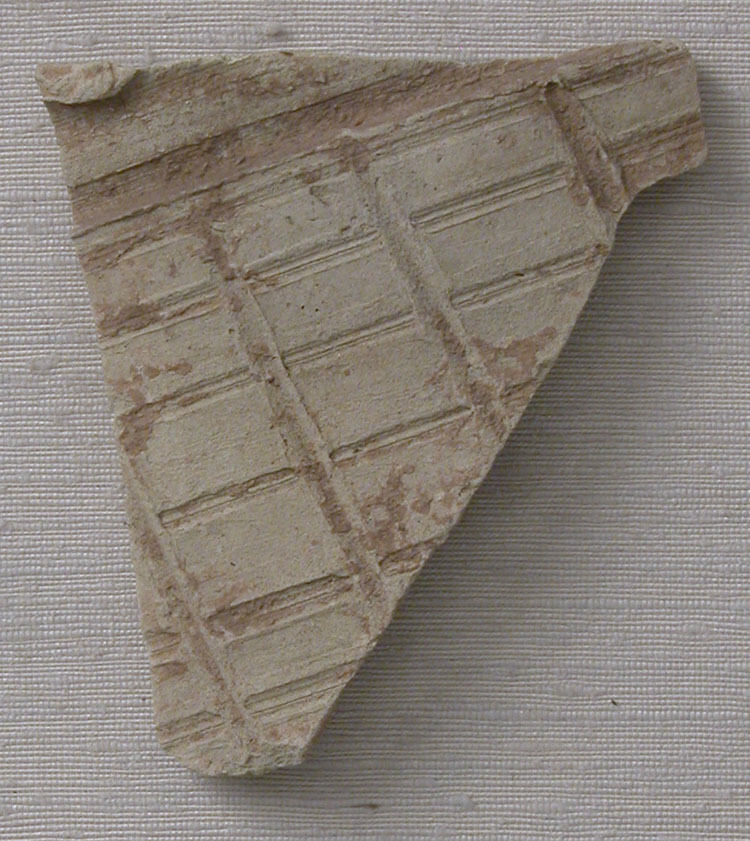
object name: fragment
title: Ceramic Fragment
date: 701-900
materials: earthenware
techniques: incising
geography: iraq